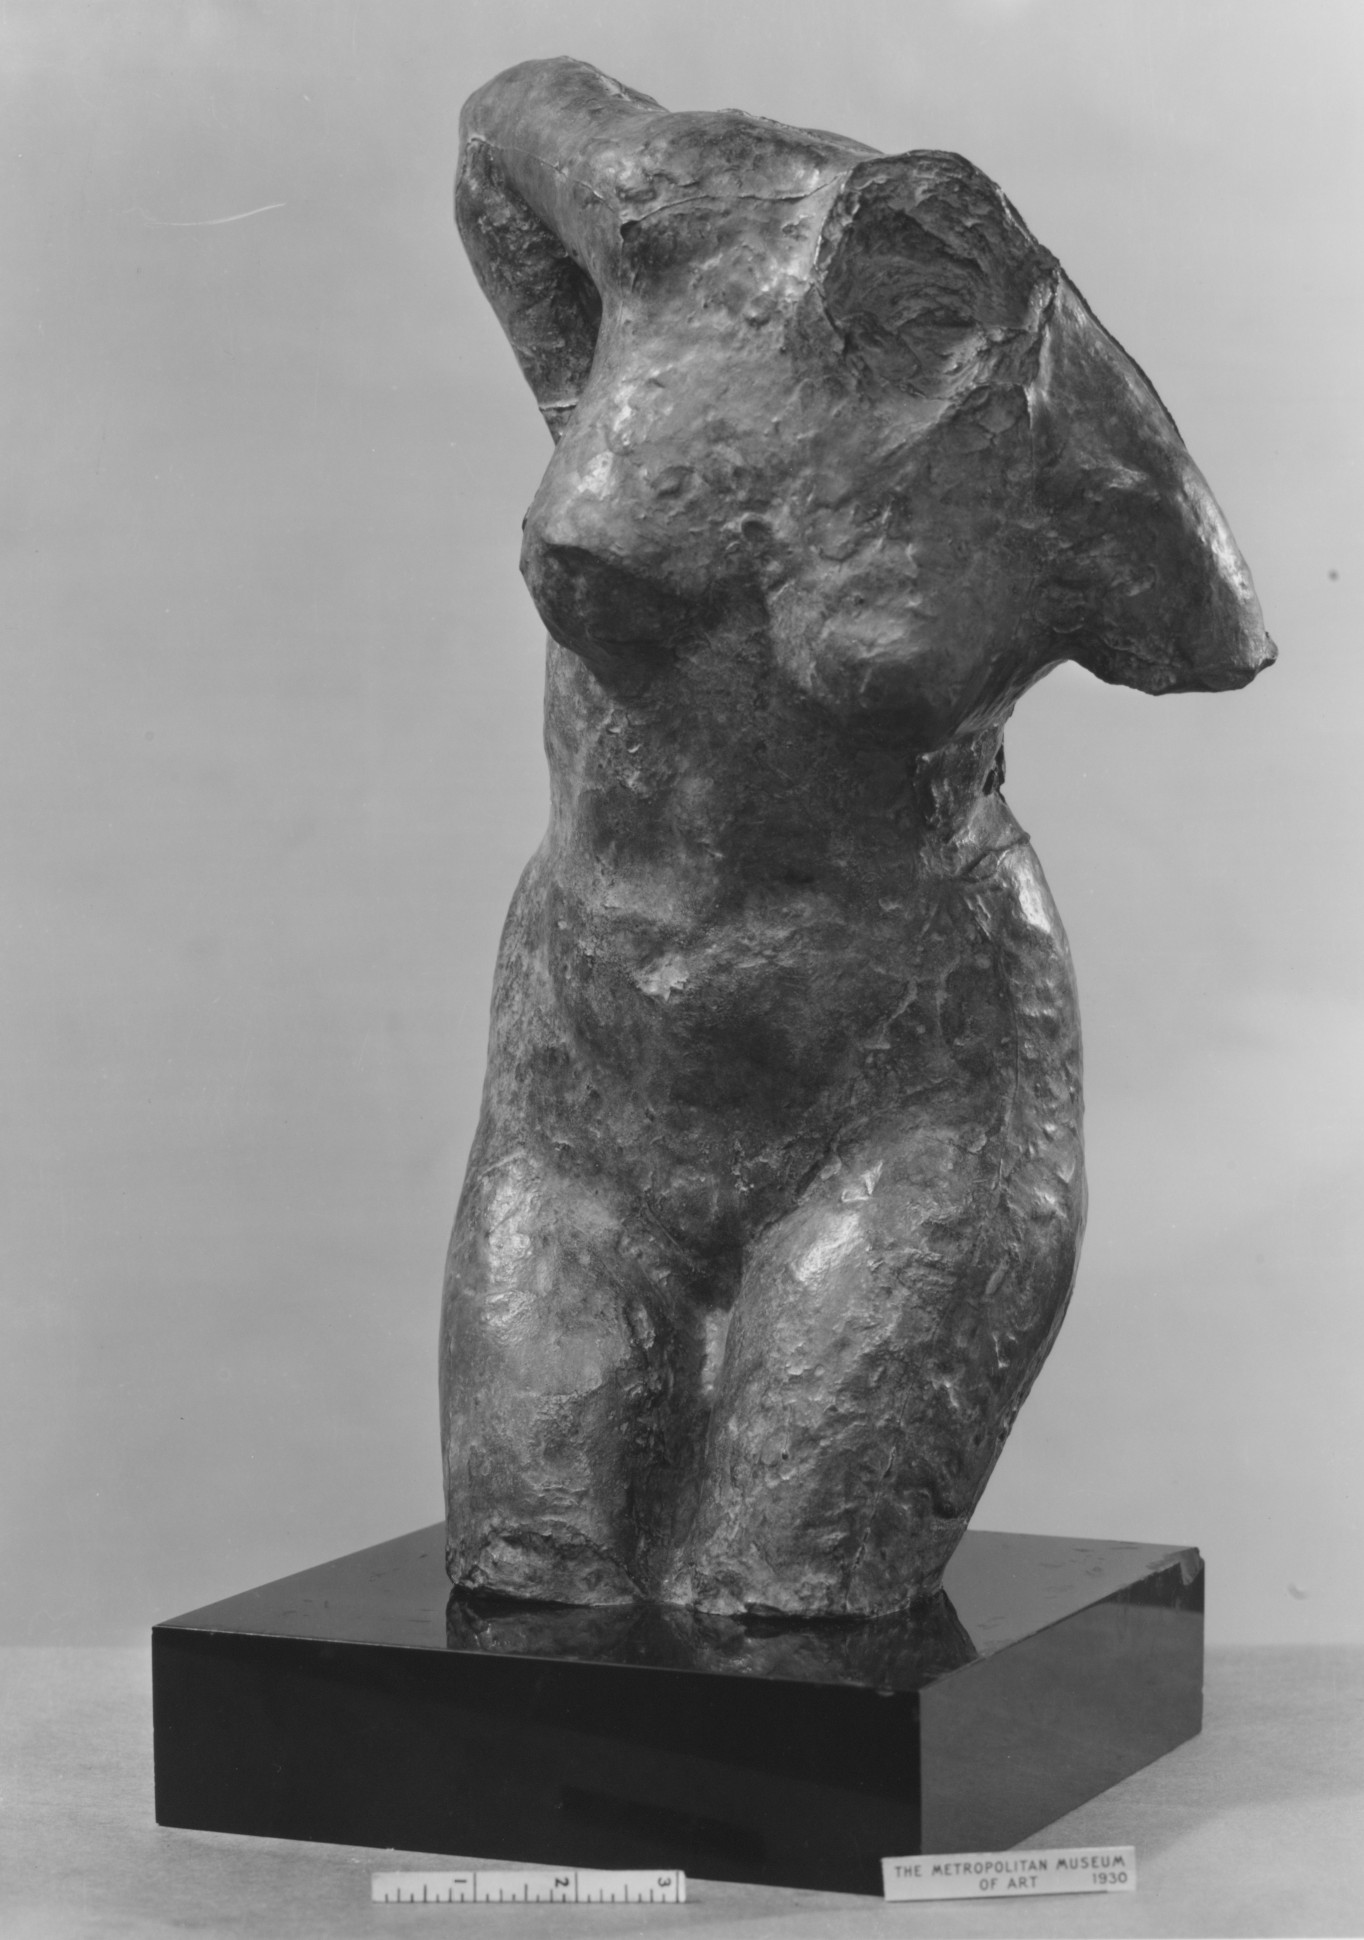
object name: torso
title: Torso: Woman Rubbing Her Back with a Sponge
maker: edgar degas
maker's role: artist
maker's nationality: french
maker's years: 1834-1917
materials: bronze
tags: female nudes